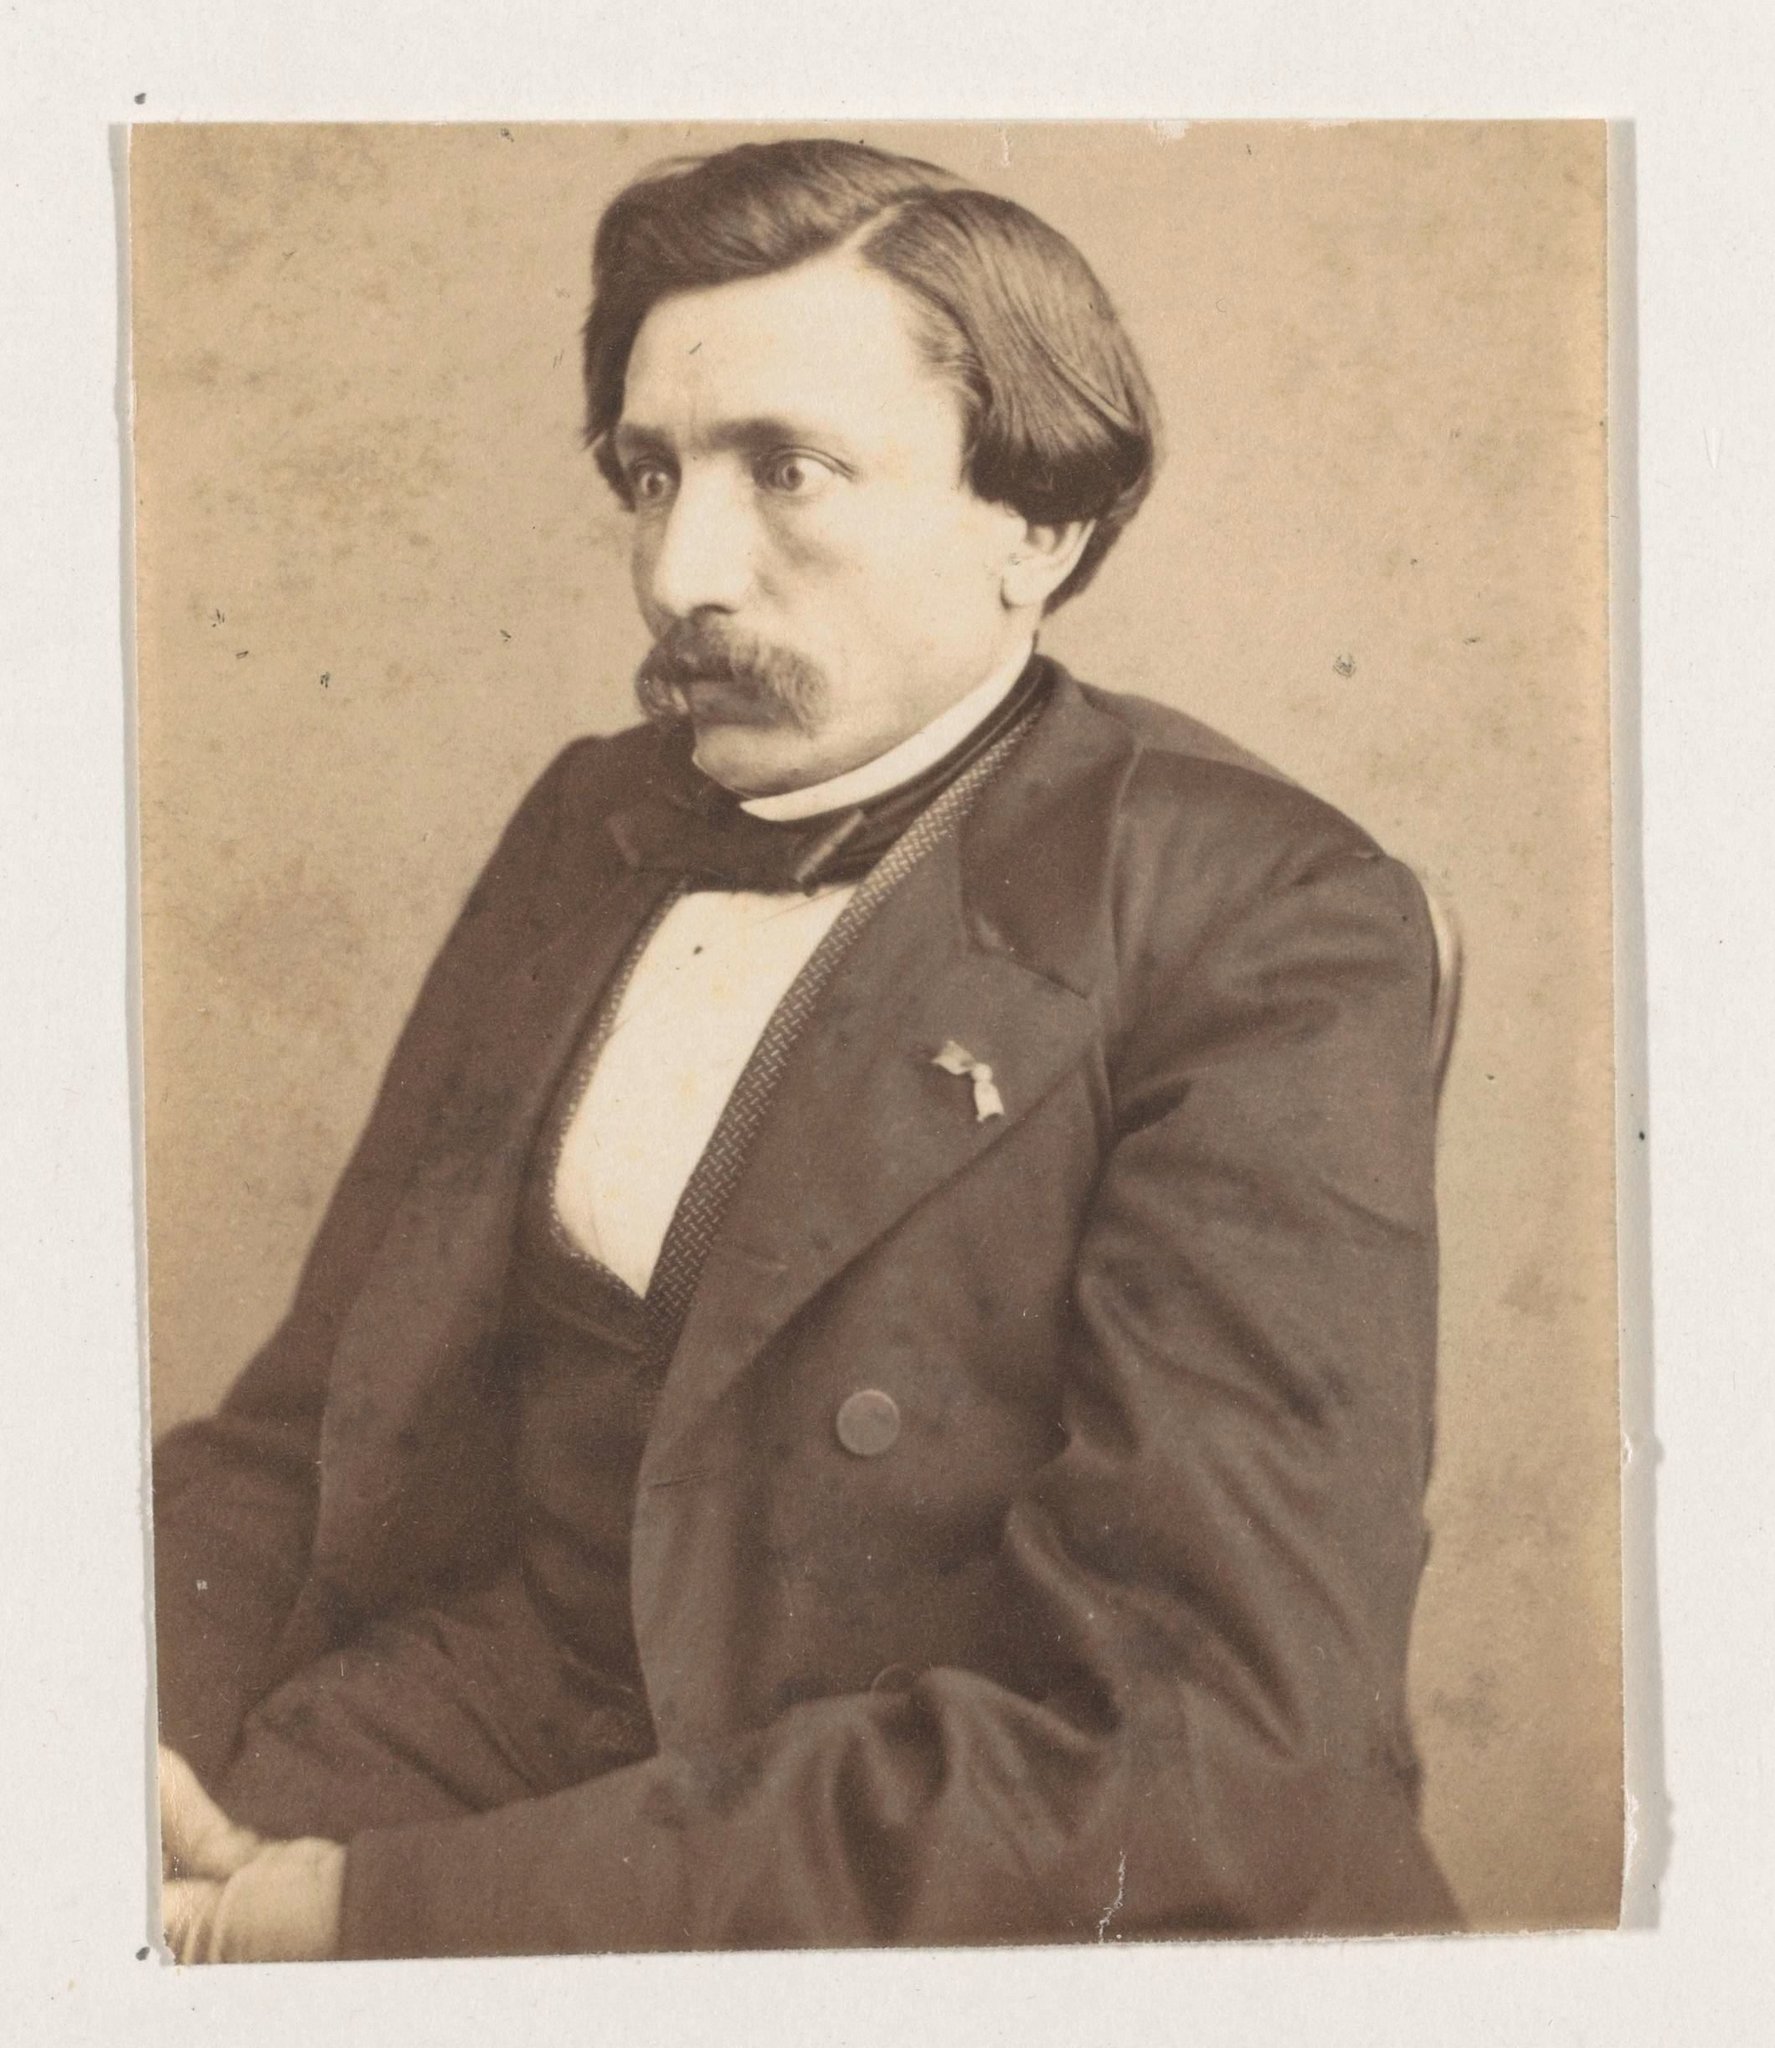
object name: photograph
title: L'École d'Anvers. Portraits biographies cartes de visite. Collection Dupont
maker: joseph dupont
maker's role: fotograaf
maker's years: 1818-1901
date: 1861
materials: cardboard, paper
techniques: albumen print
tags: engraver, etcher, historical persons, portrait, self-portrait of artist